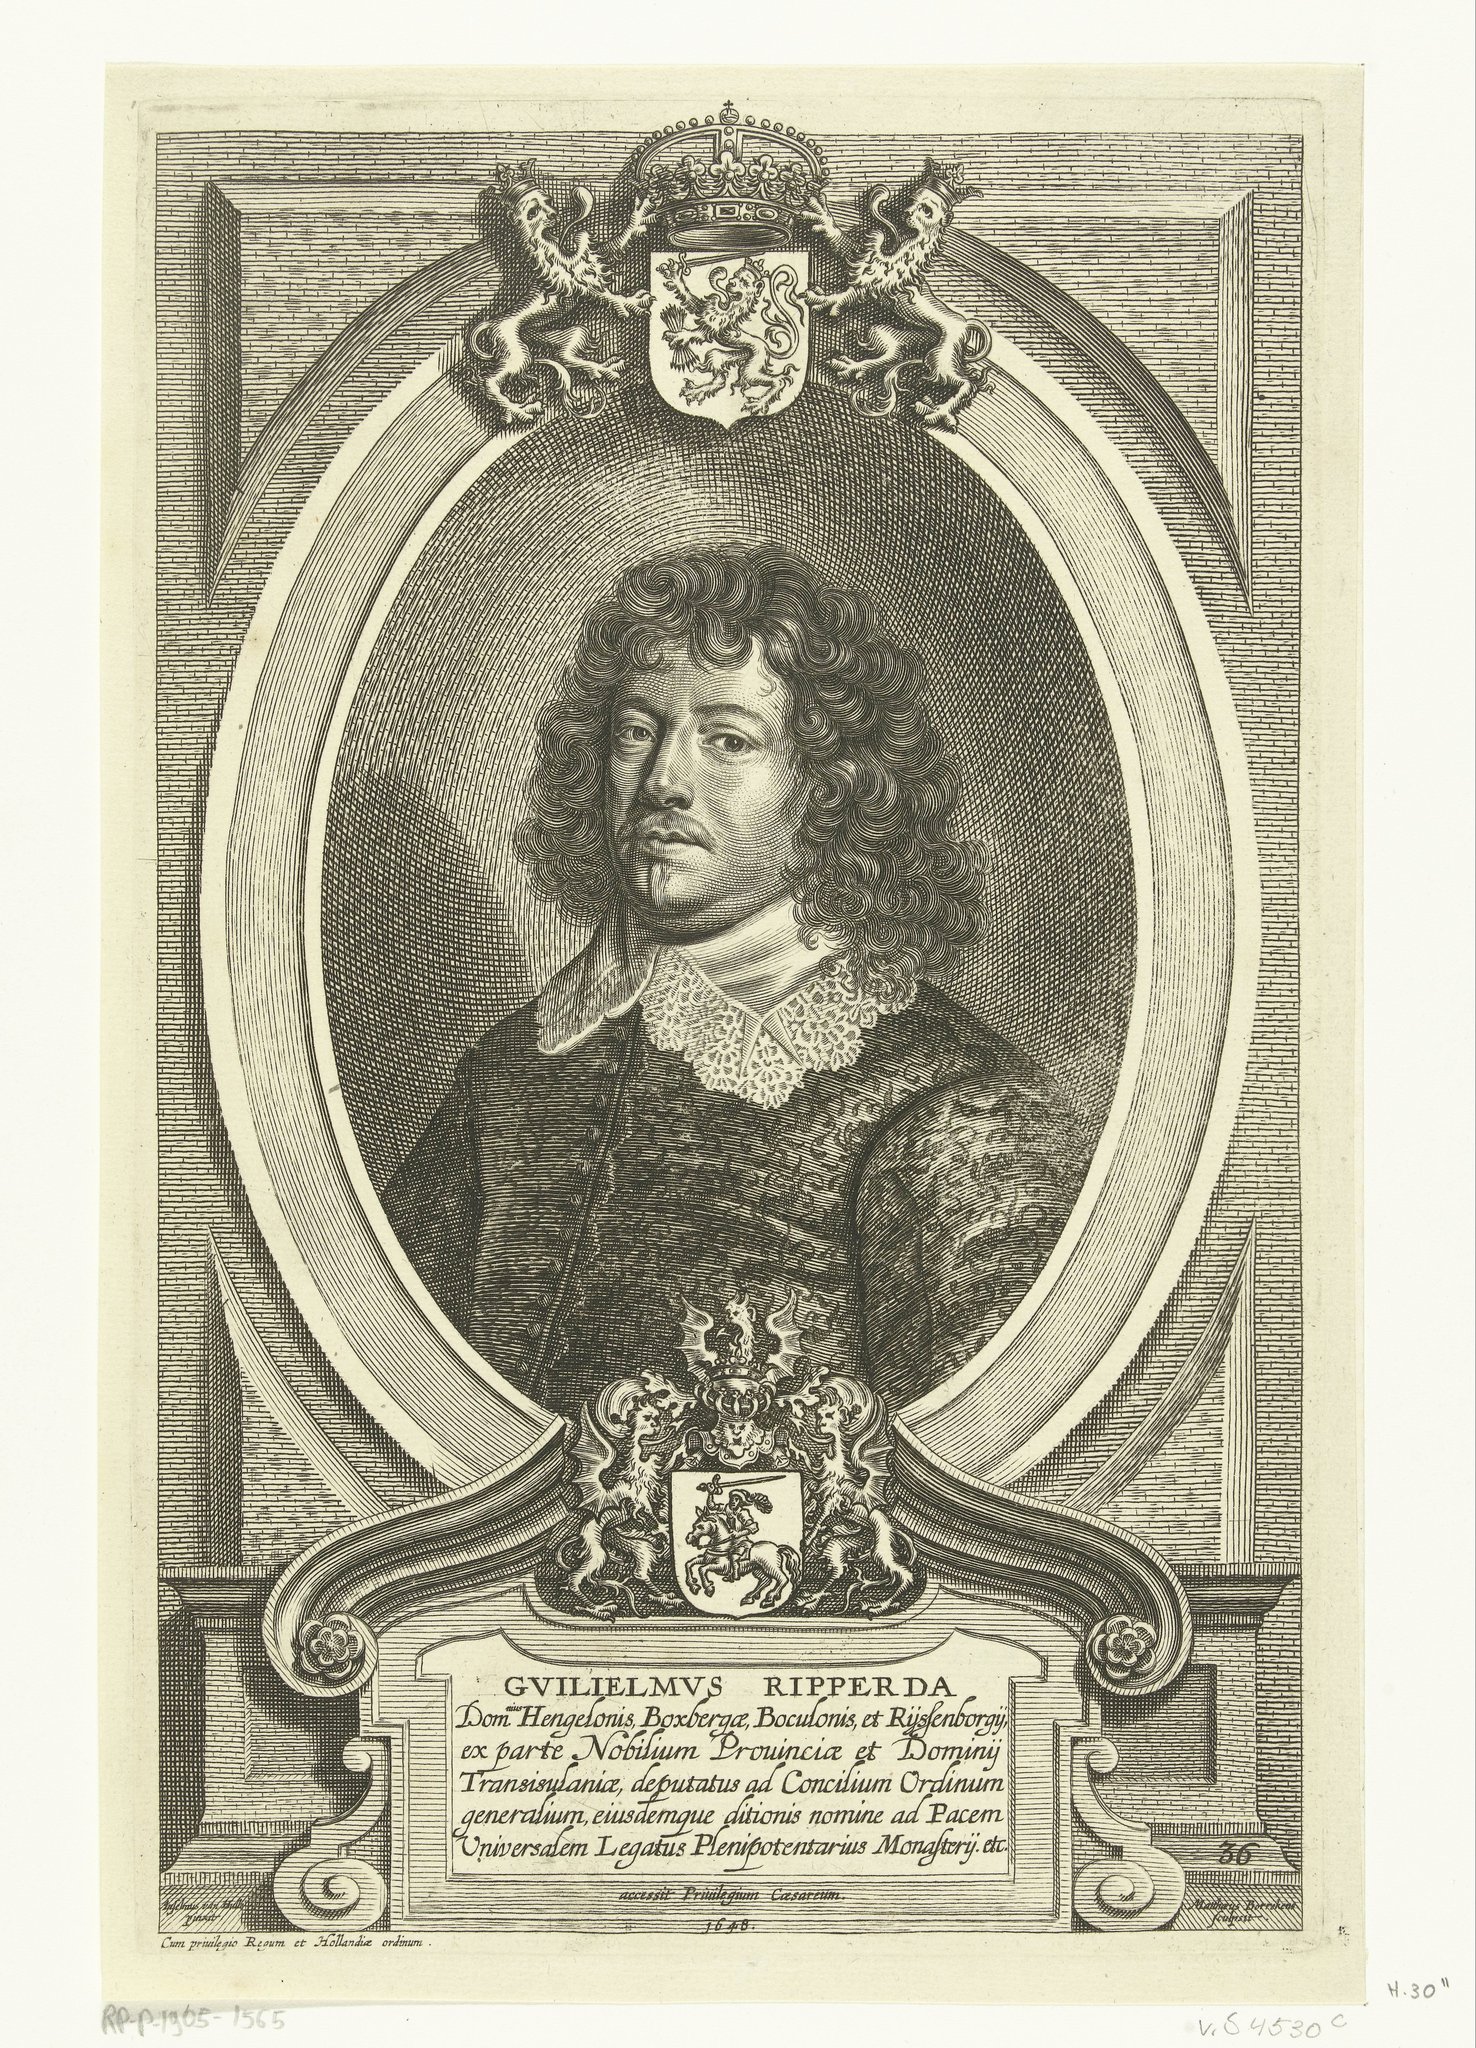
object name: print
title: Portretten van onderhandelaars bij de Vrede van Munster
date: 1648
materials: paper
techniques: engraving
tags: willem van ripperda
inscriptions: collector's mark: Lugt 2228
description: Willem Ripperda, onderhandelaar bij de Vrede van Munster. Portret in ovale lijst met buste naar links. De prent bevat een Latijns onderschrift in cartouche, een randschrift en ornament met wapen bovenaan.